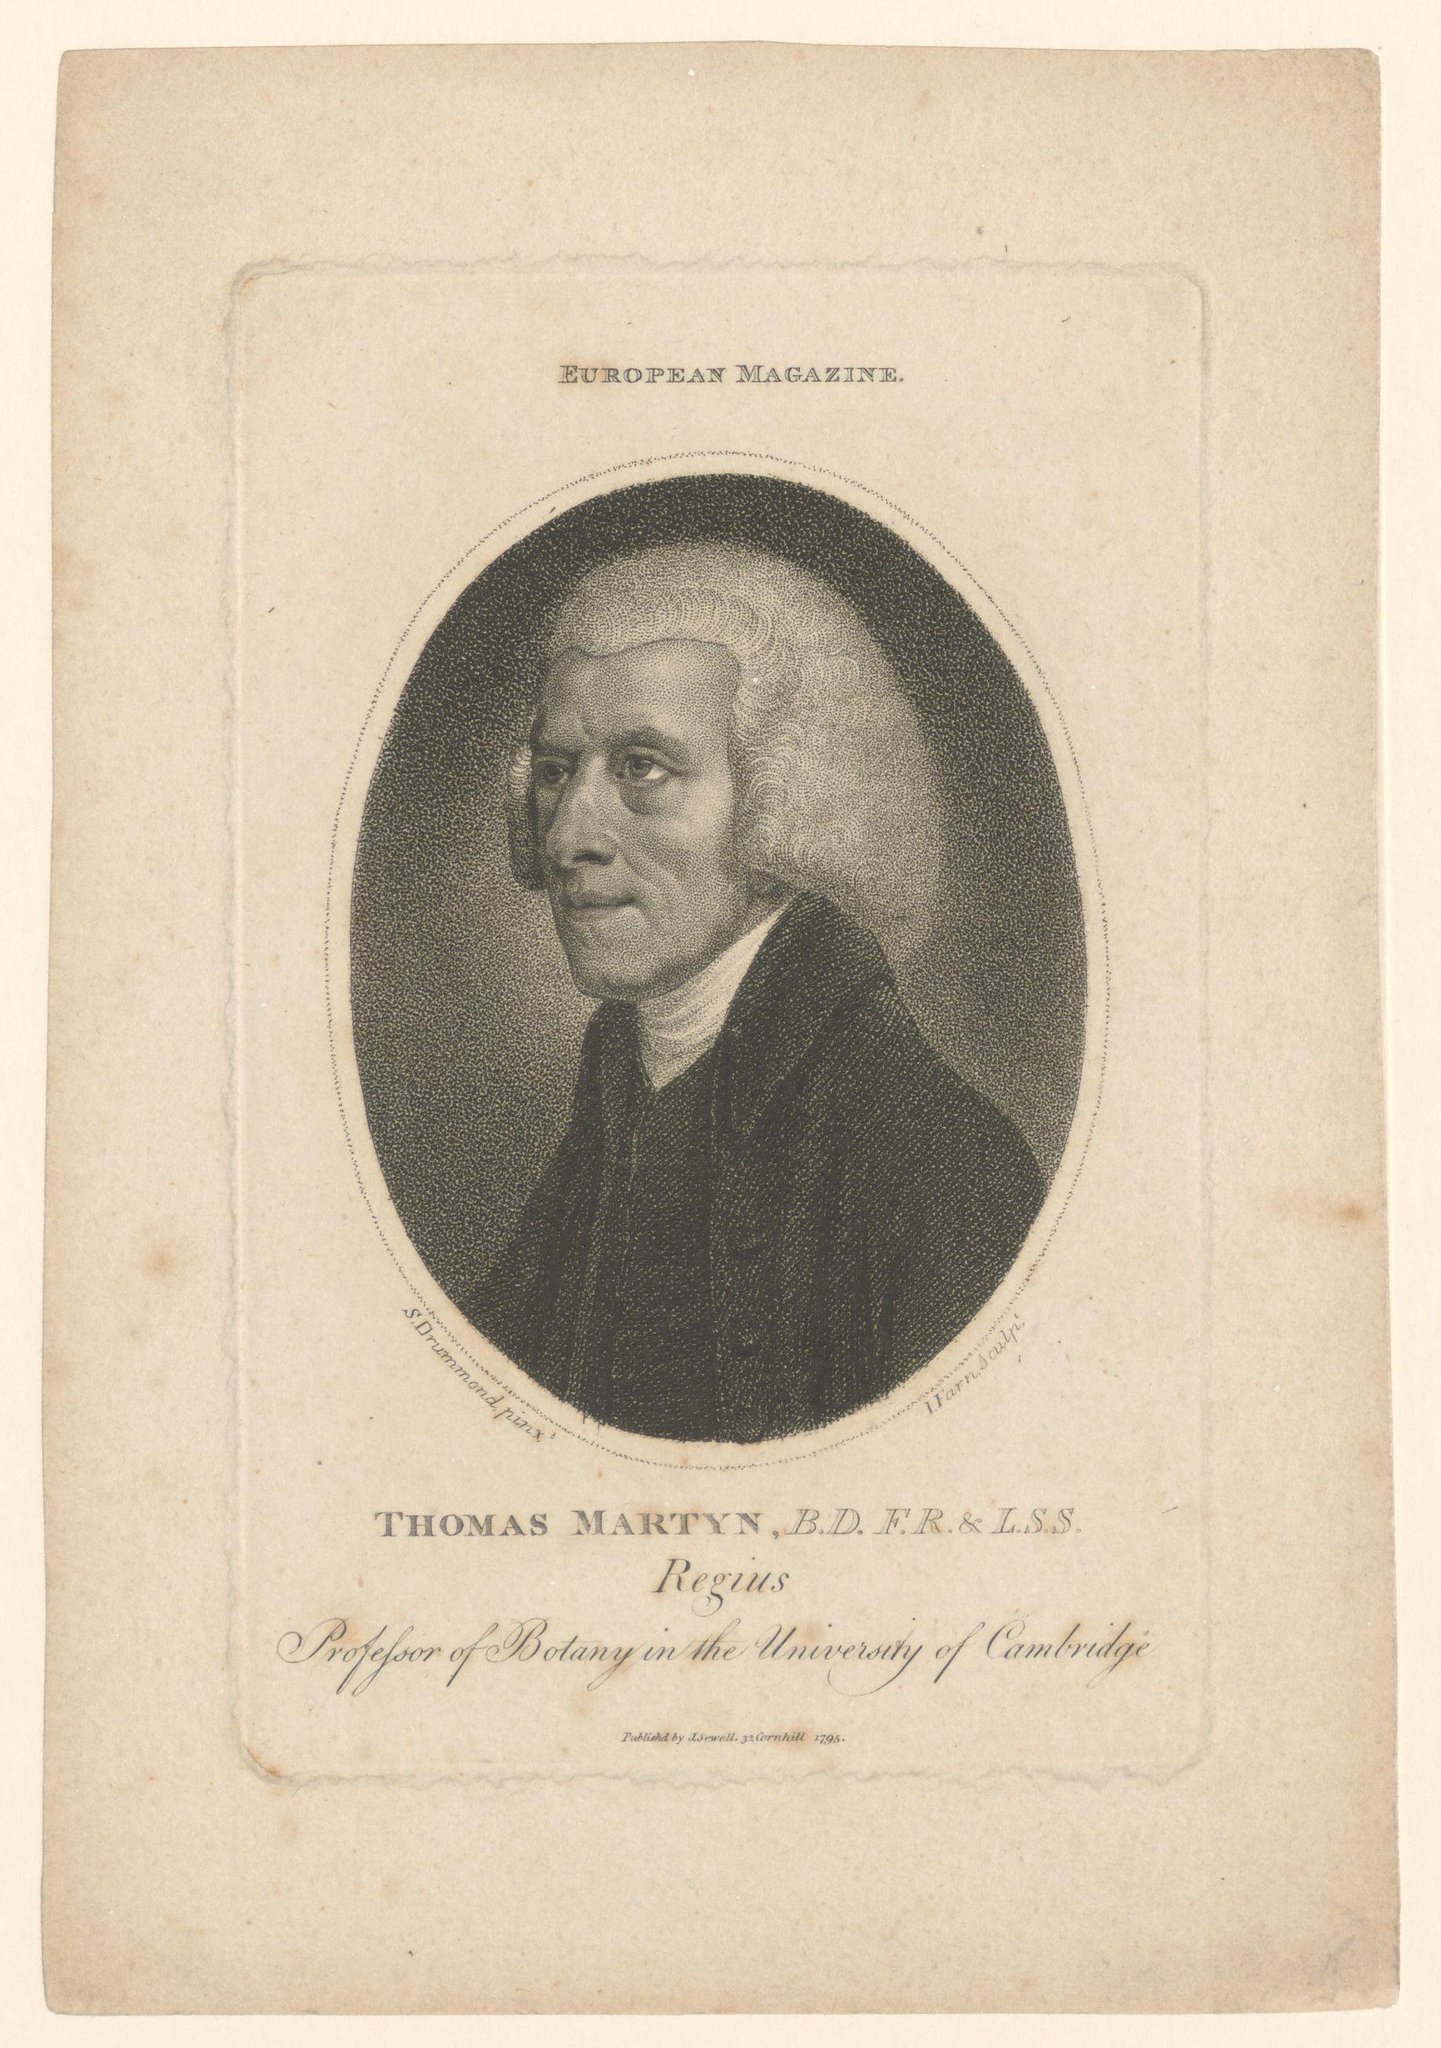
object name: print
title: Thomas Martyn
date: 1795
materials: paper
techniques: etching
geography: london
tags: botany (+ portrait of scholar, scientist), historical persons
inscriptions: collector's mark: Lugt 2228